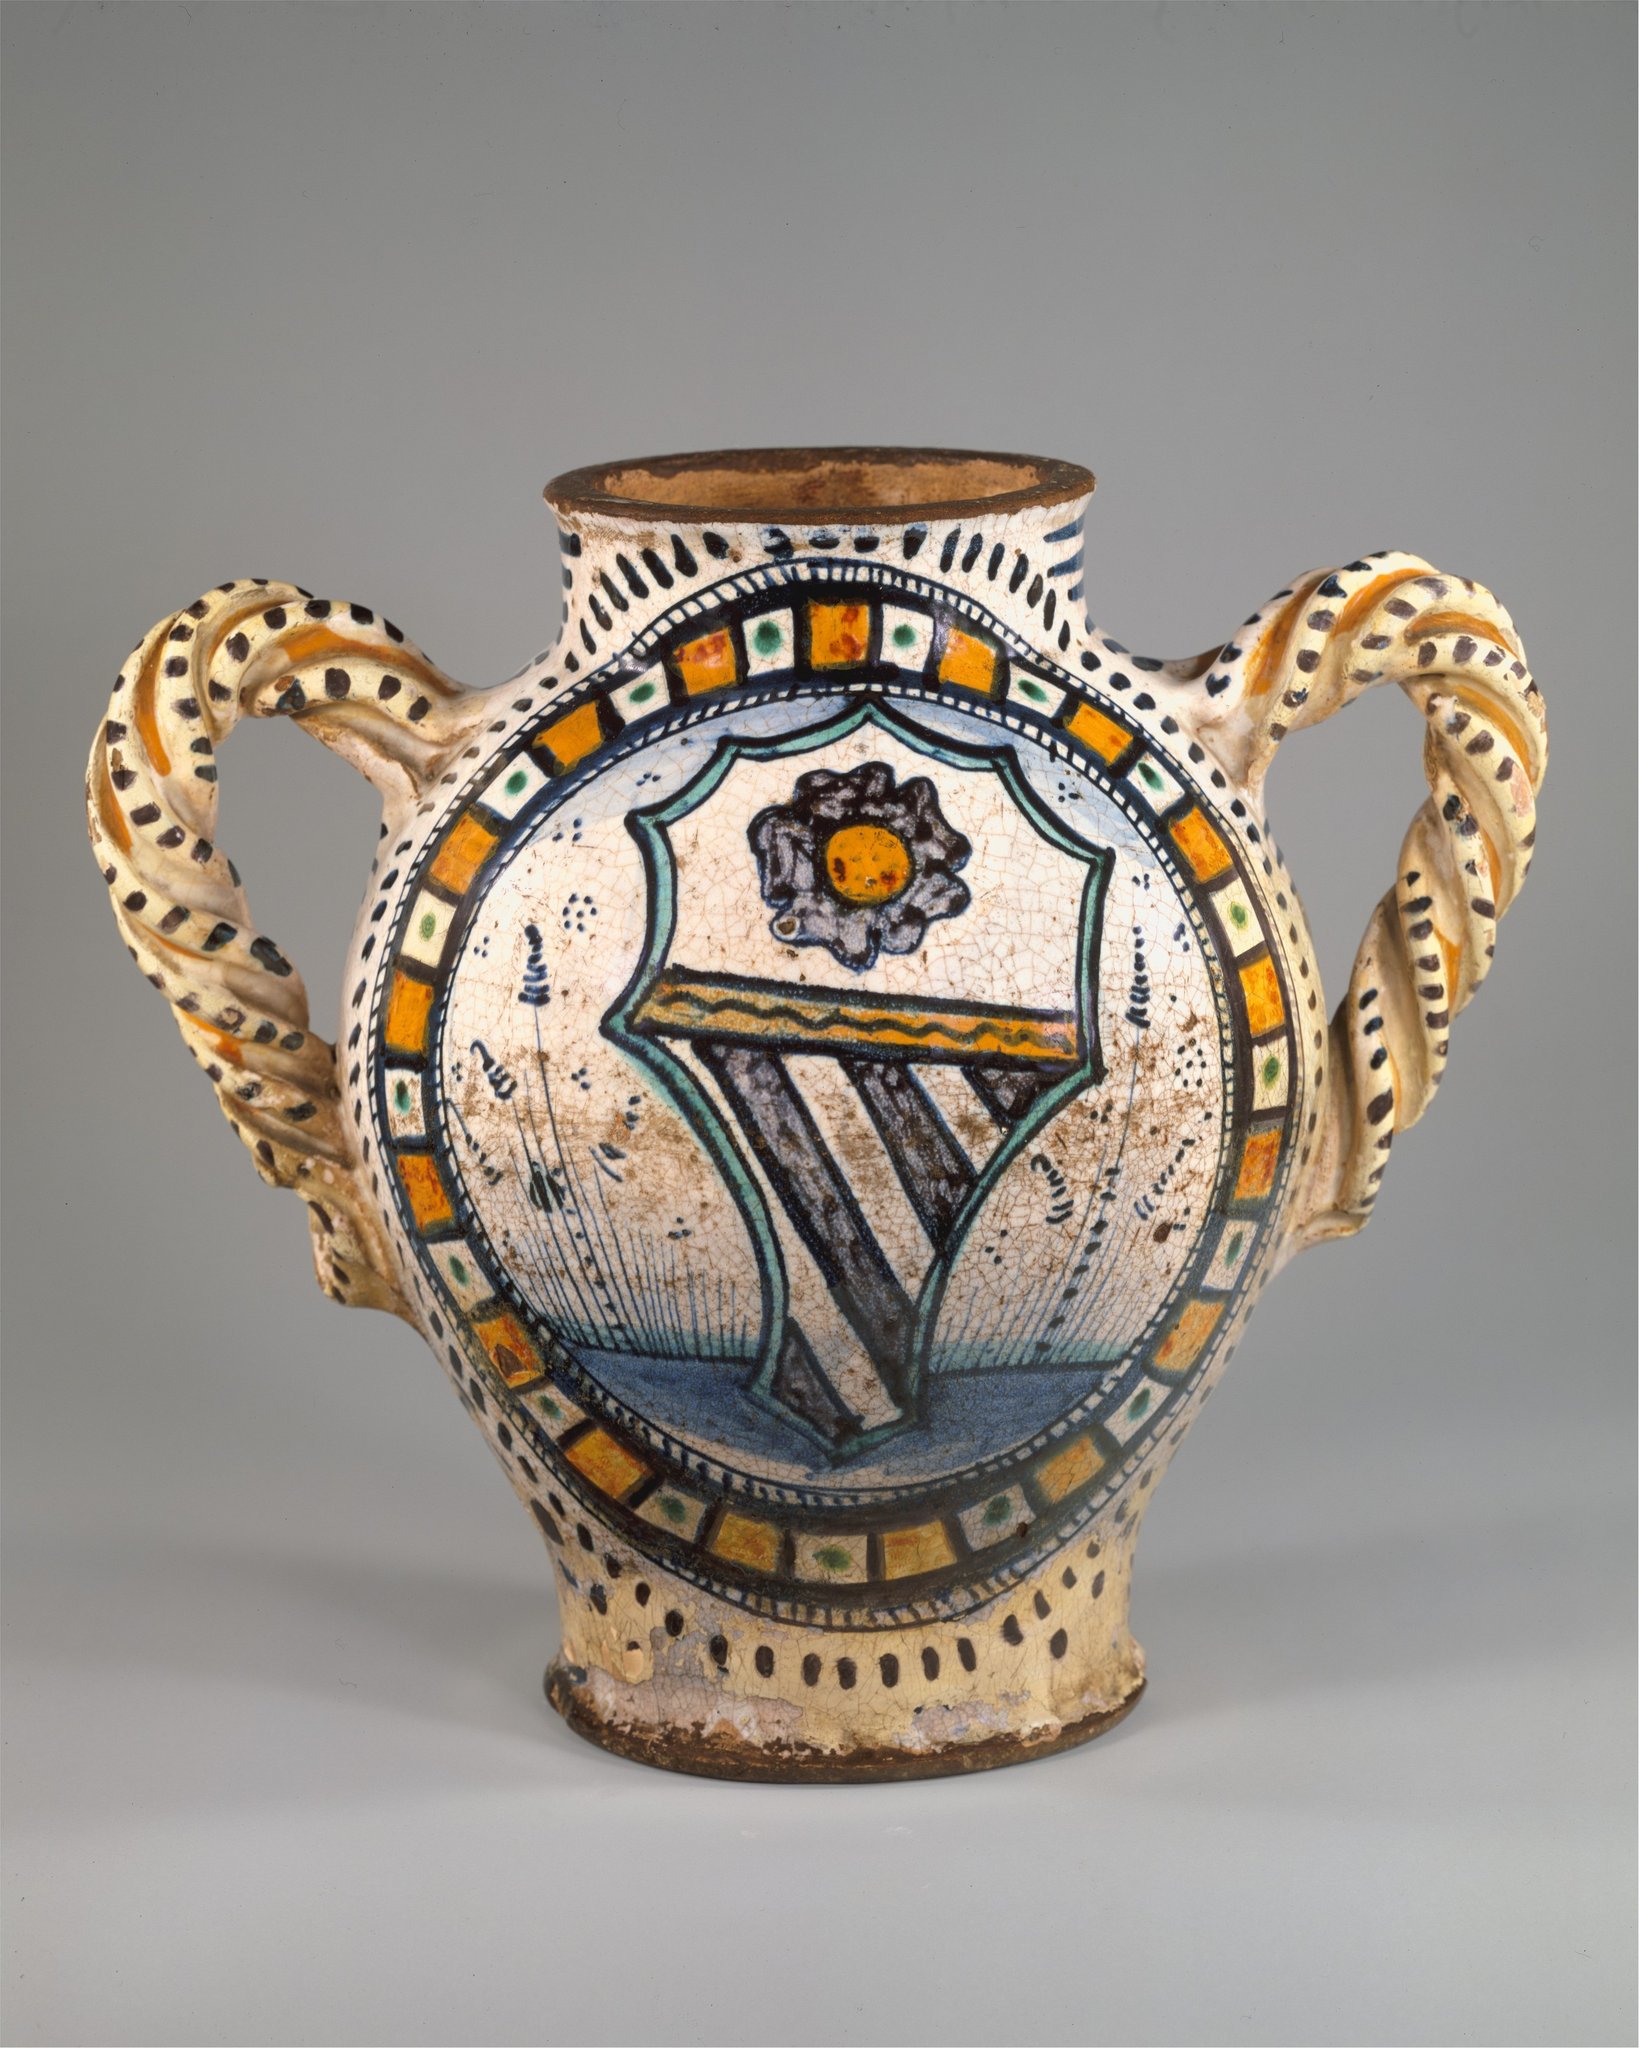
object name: jug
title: Armorial Jug (vaso)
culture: italian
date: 1480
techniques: maiolica, glazing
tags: coat of arms